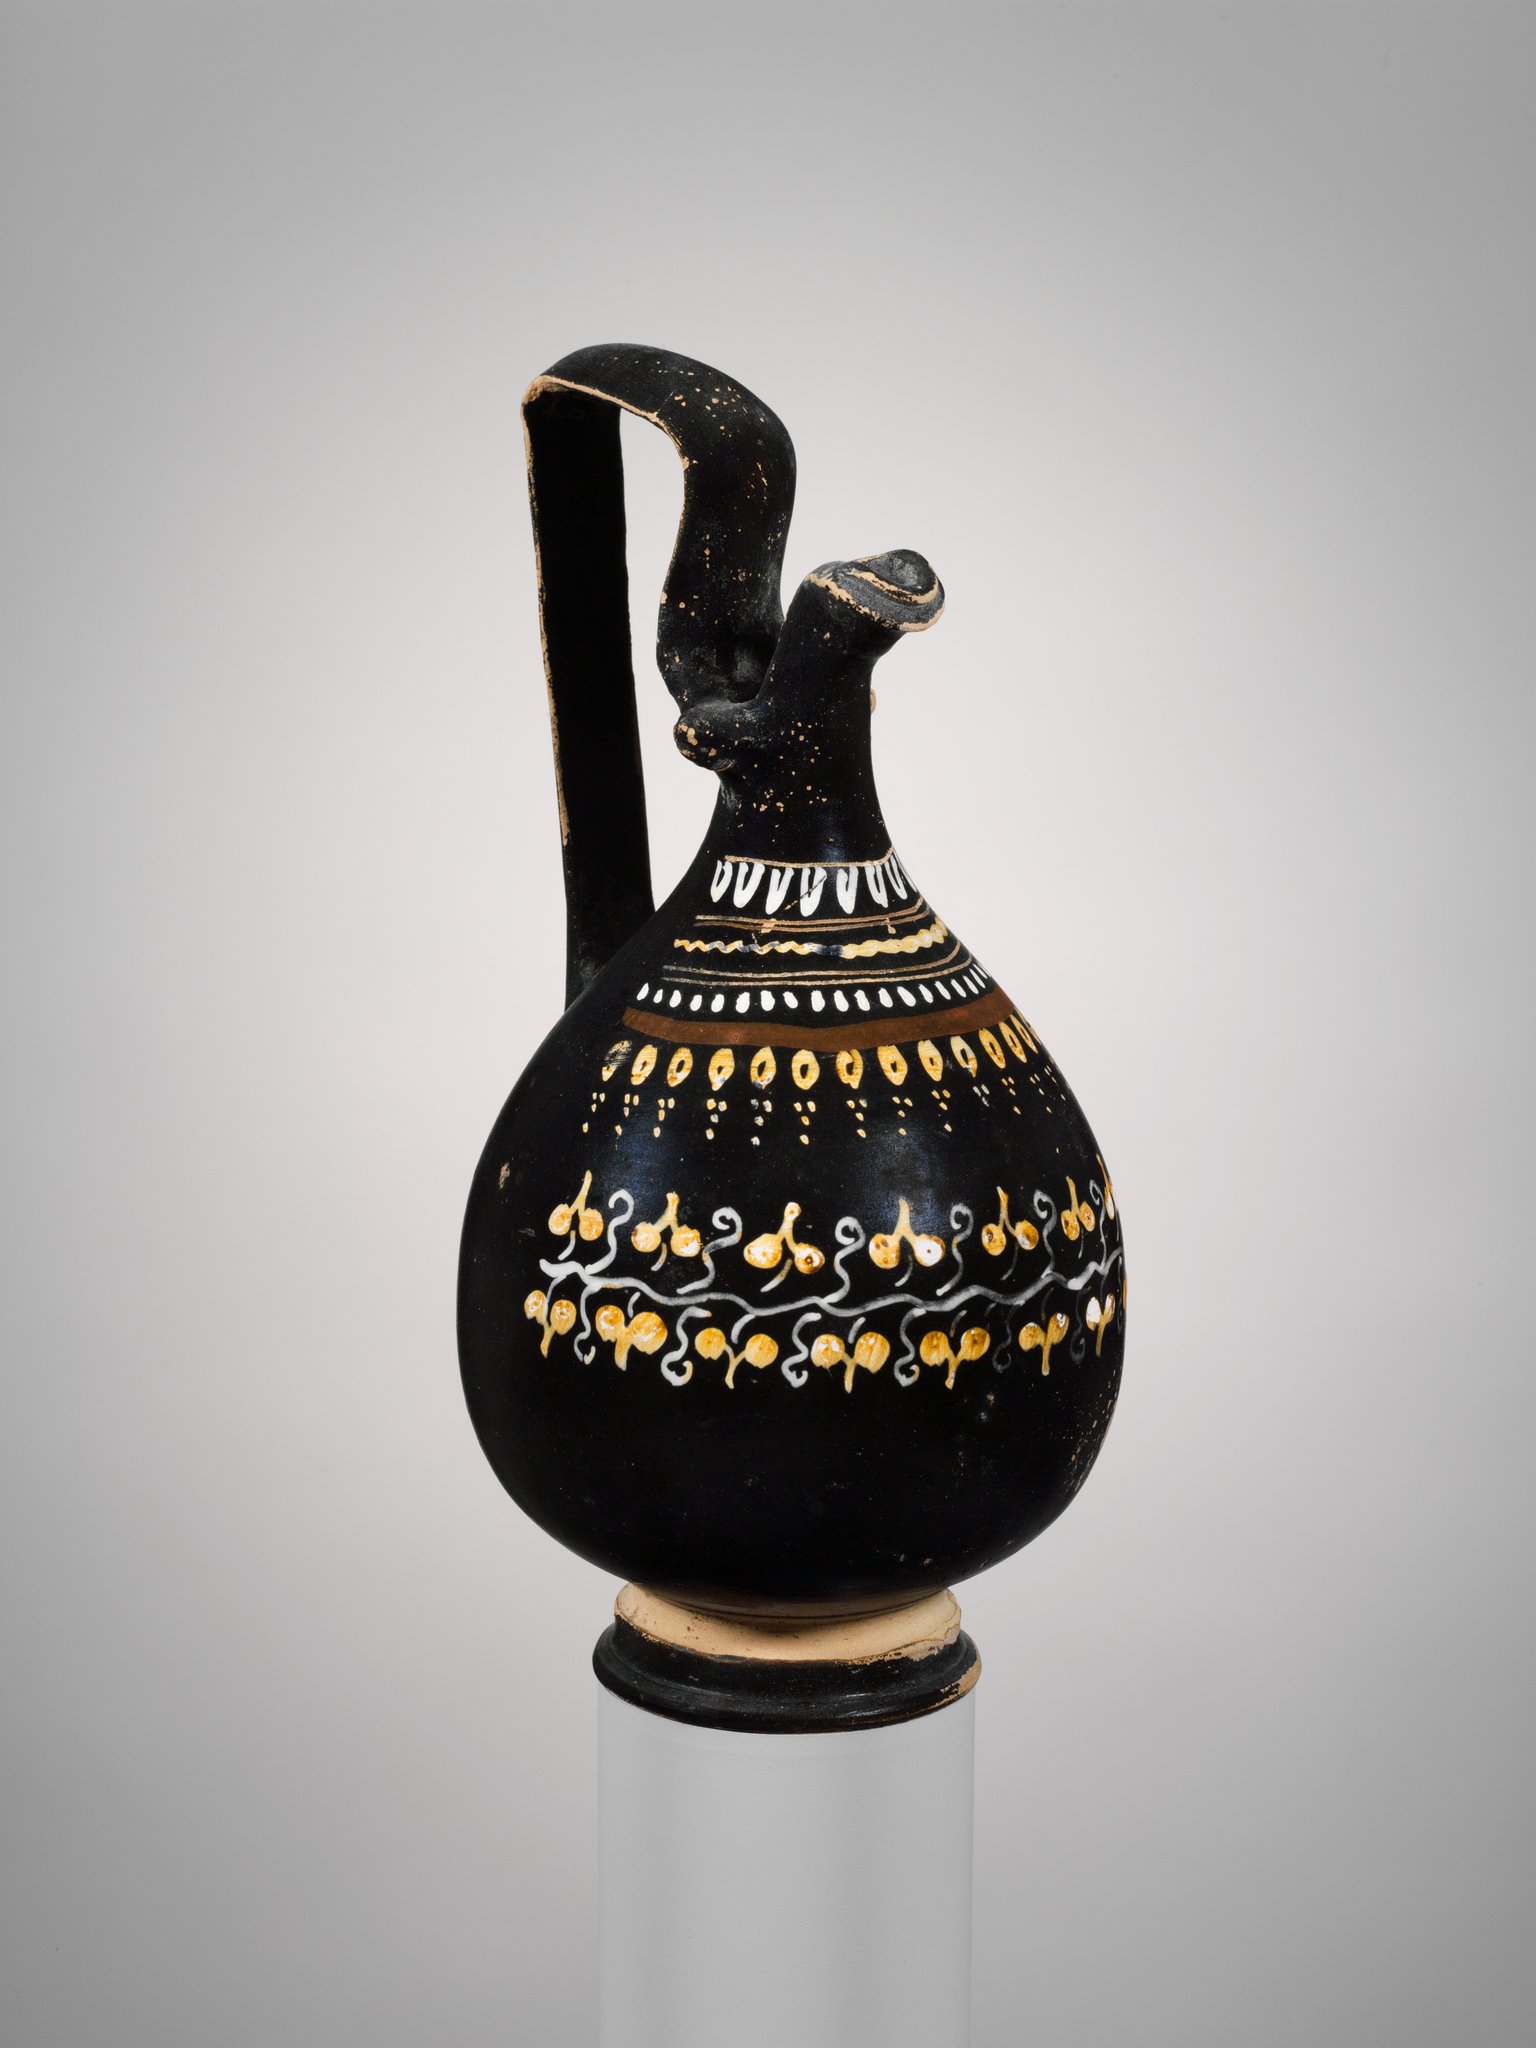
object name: oinochoe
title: Terracotta oinochoe (jug)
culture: greek, south italian, apulian, canosan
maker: knudsen group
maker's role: artist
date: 350-330 BCE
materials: terracotta